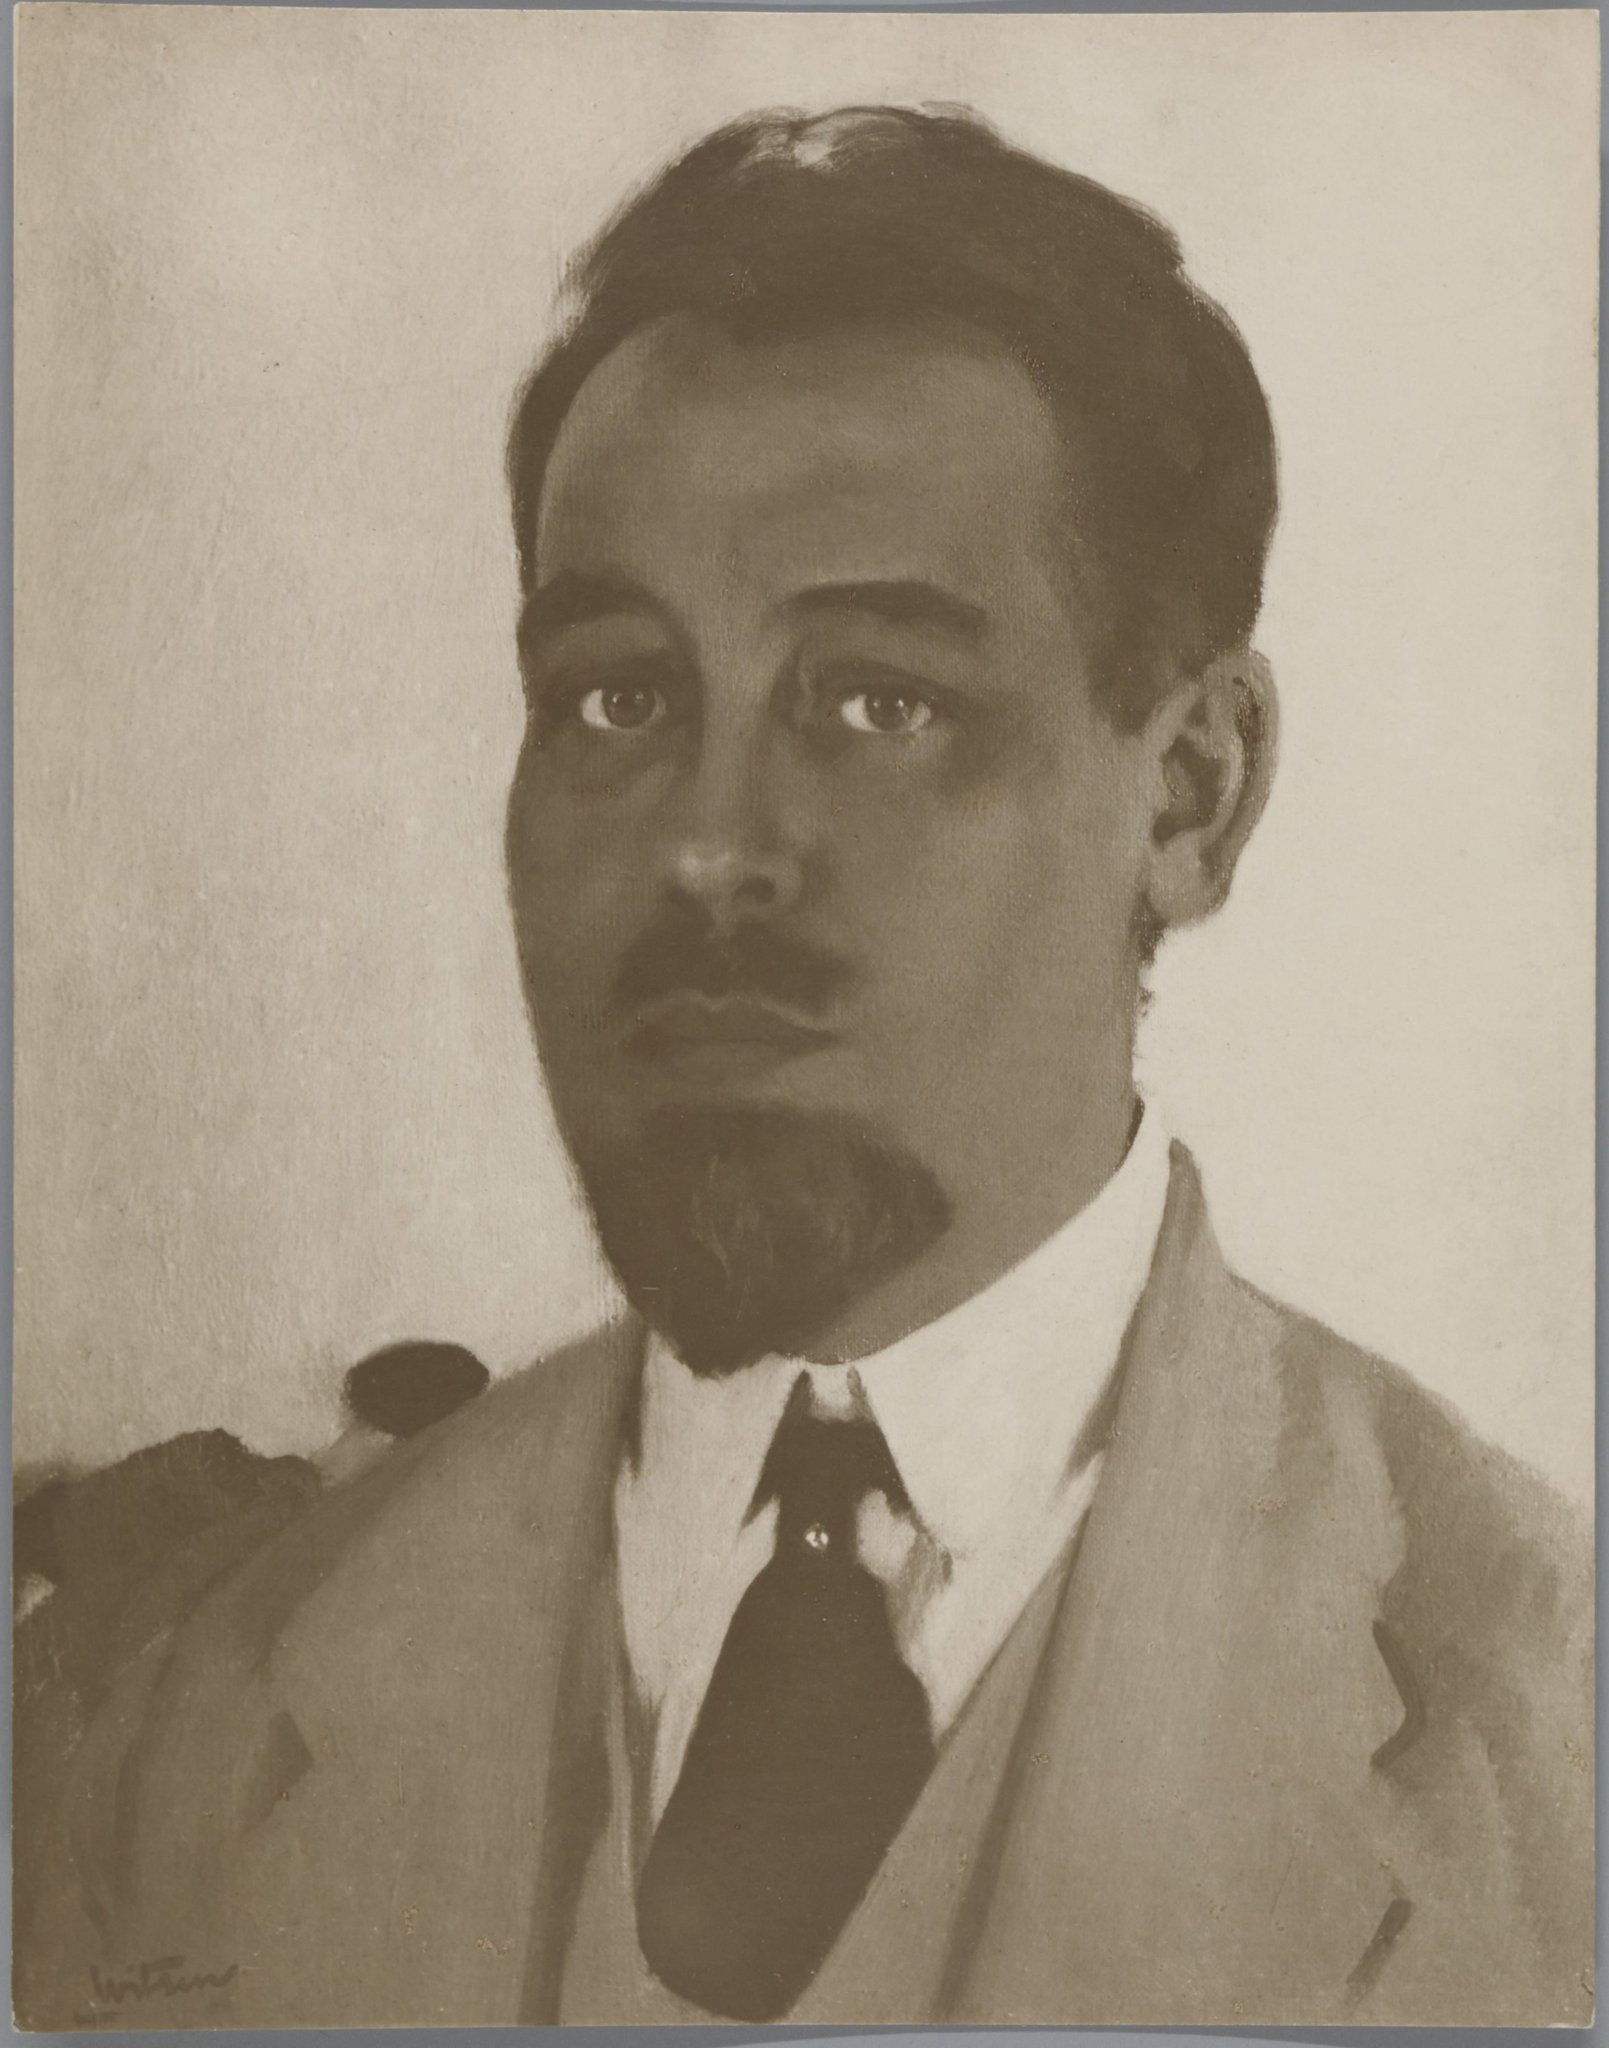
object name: photograph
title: Reproductie naar schilderij van Willem Witsen van een portret van een man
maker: Anonymous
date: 1860-1915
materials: paper, photographic support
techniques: gelatin silver print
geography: netherlands